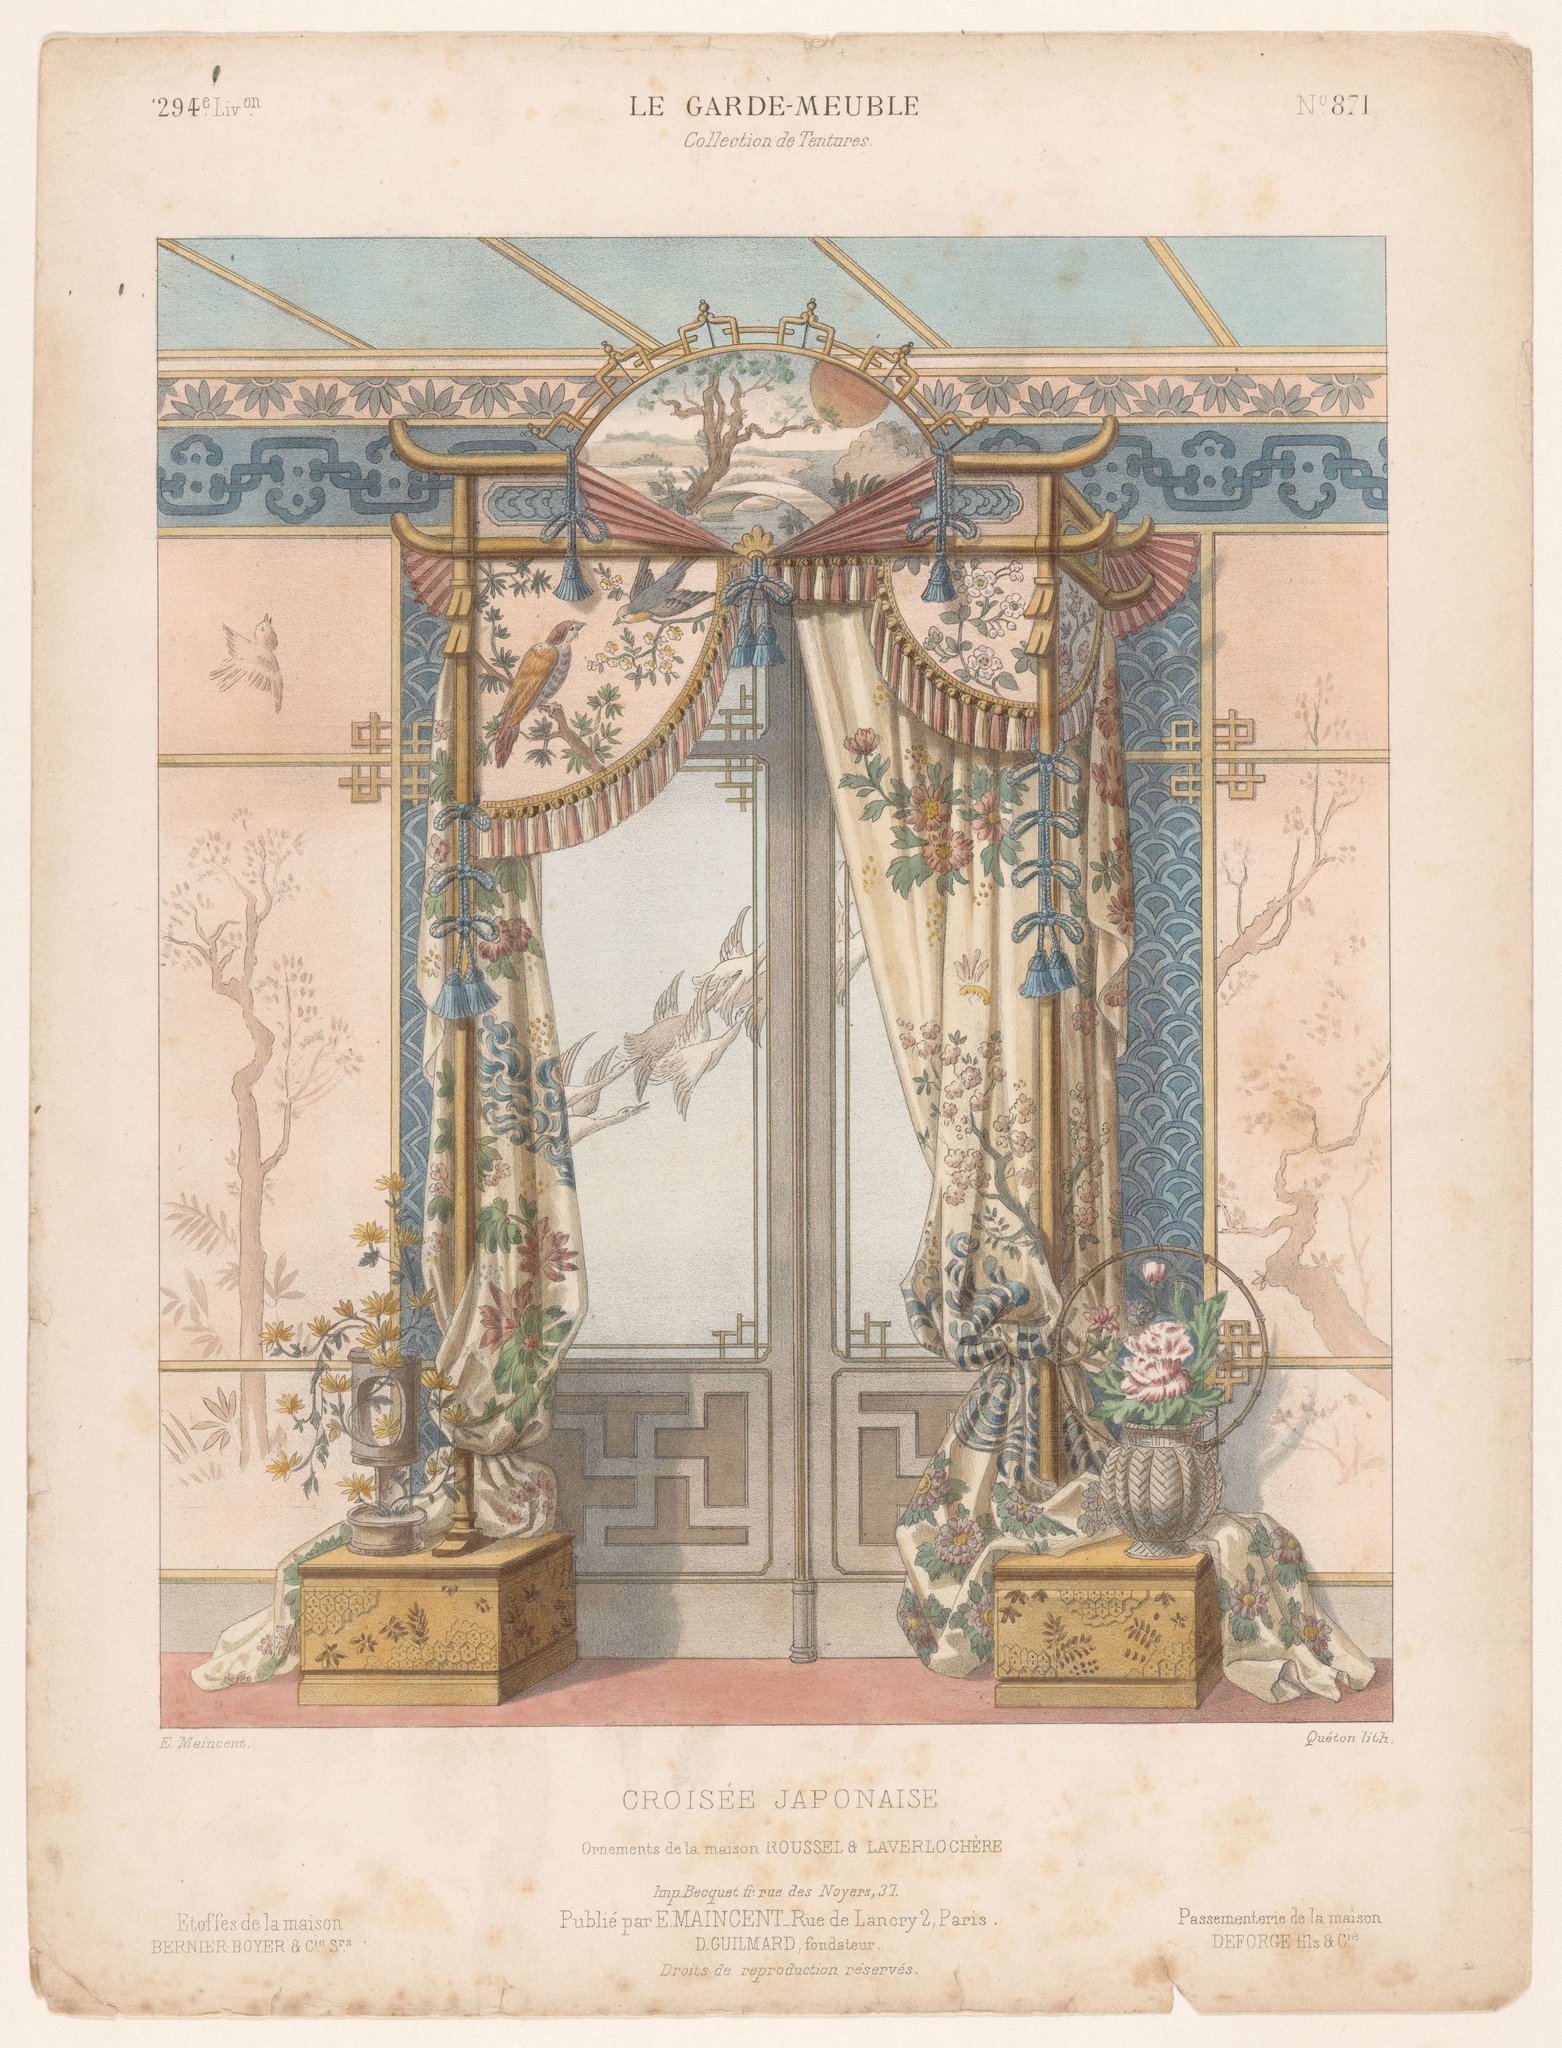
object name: print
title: Croisée Japonaise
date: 1885-1895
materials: paper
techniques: hand coloring, lithograph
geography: paris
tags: window, hangings and drapery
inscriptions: : ‘Droits de reproduction réservés.’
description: Kruisvenster met gedrapeerde gordijnen in Japanse stijl. Prent uit 294e Livraison.